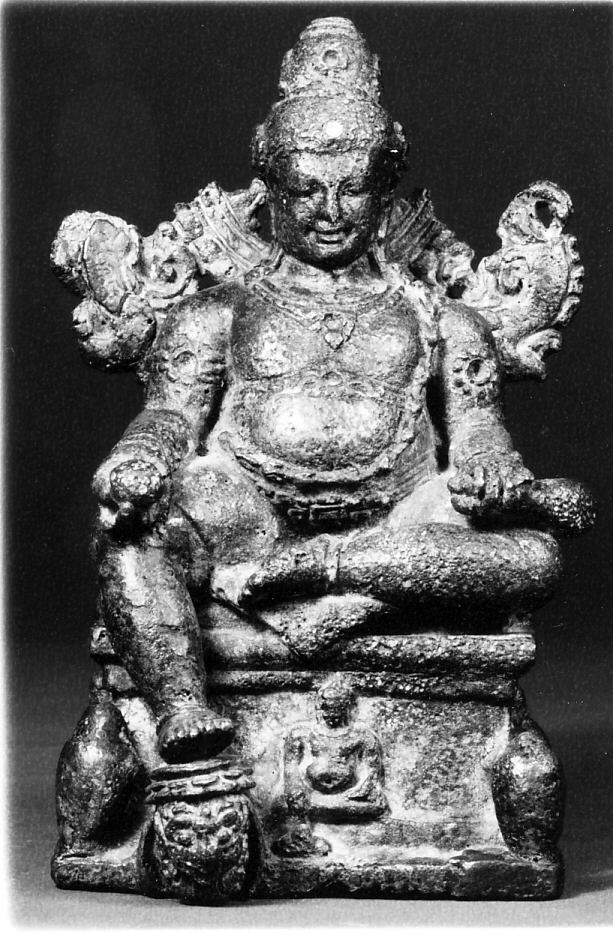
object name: figure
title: Seated Kuvera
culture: indonesian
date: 801-900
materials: bronze